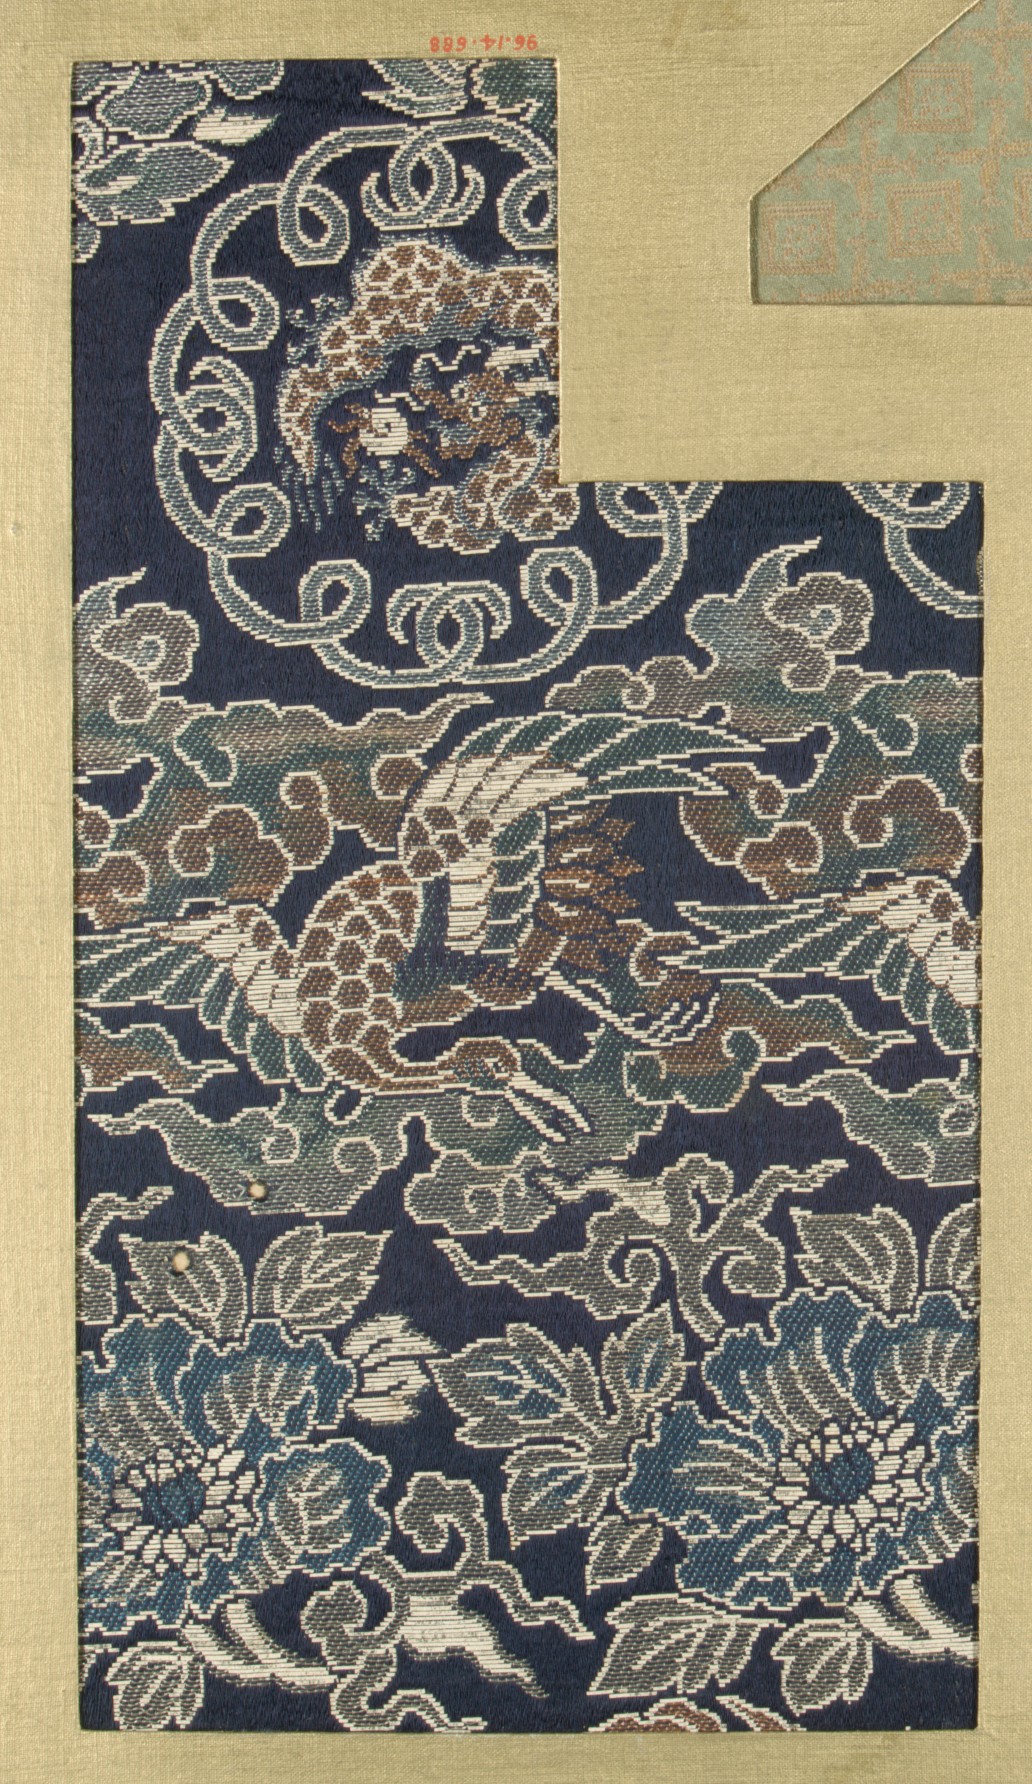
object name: piece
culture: japanese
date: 1701-1900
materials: silk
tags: birds,leaves